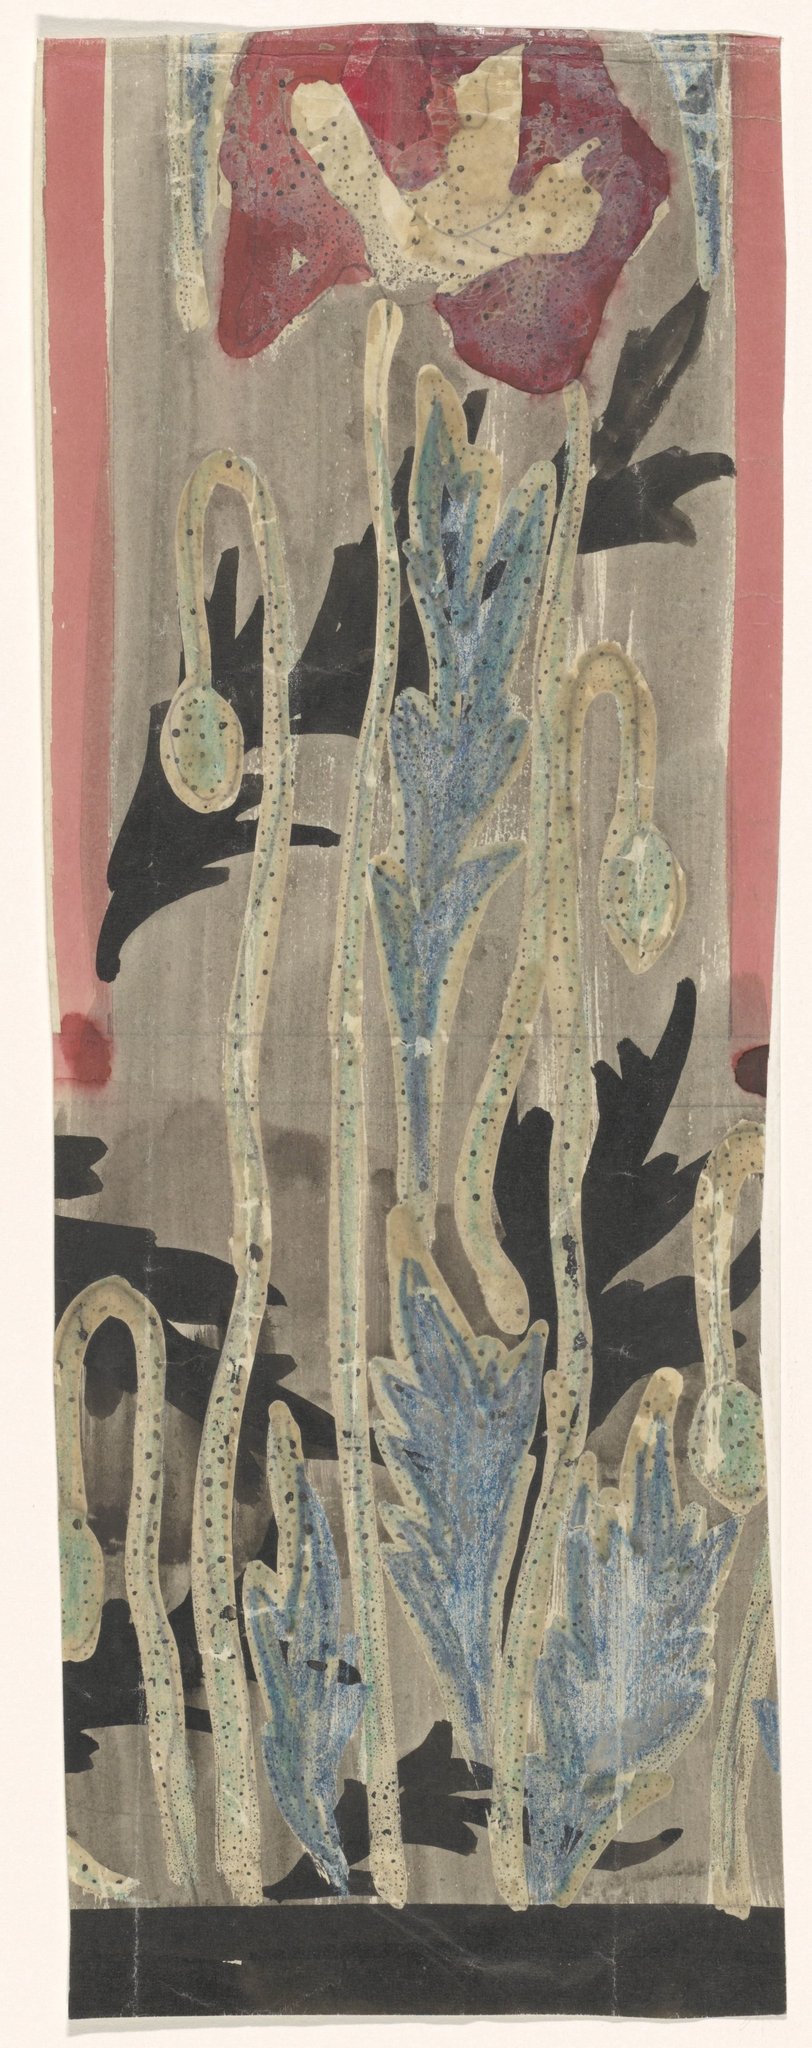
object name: design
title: Ontwerp met papavers voor de rand van het wandtapijt Gezicht op Florence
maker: carel adolph lion cachet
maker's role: draughtsman, print maker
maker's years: 1864-1945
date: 1925-1926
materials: paper, pencil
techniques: brush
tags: flowers: poppy, flowers ~ ornament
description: Ontwerp voor het wandtapijt Gezicht op de Ponte Vecchio te Florence, voor de eetsalon van het schip de P.C. Hooft, uitgevoerd door J.F. Semey.